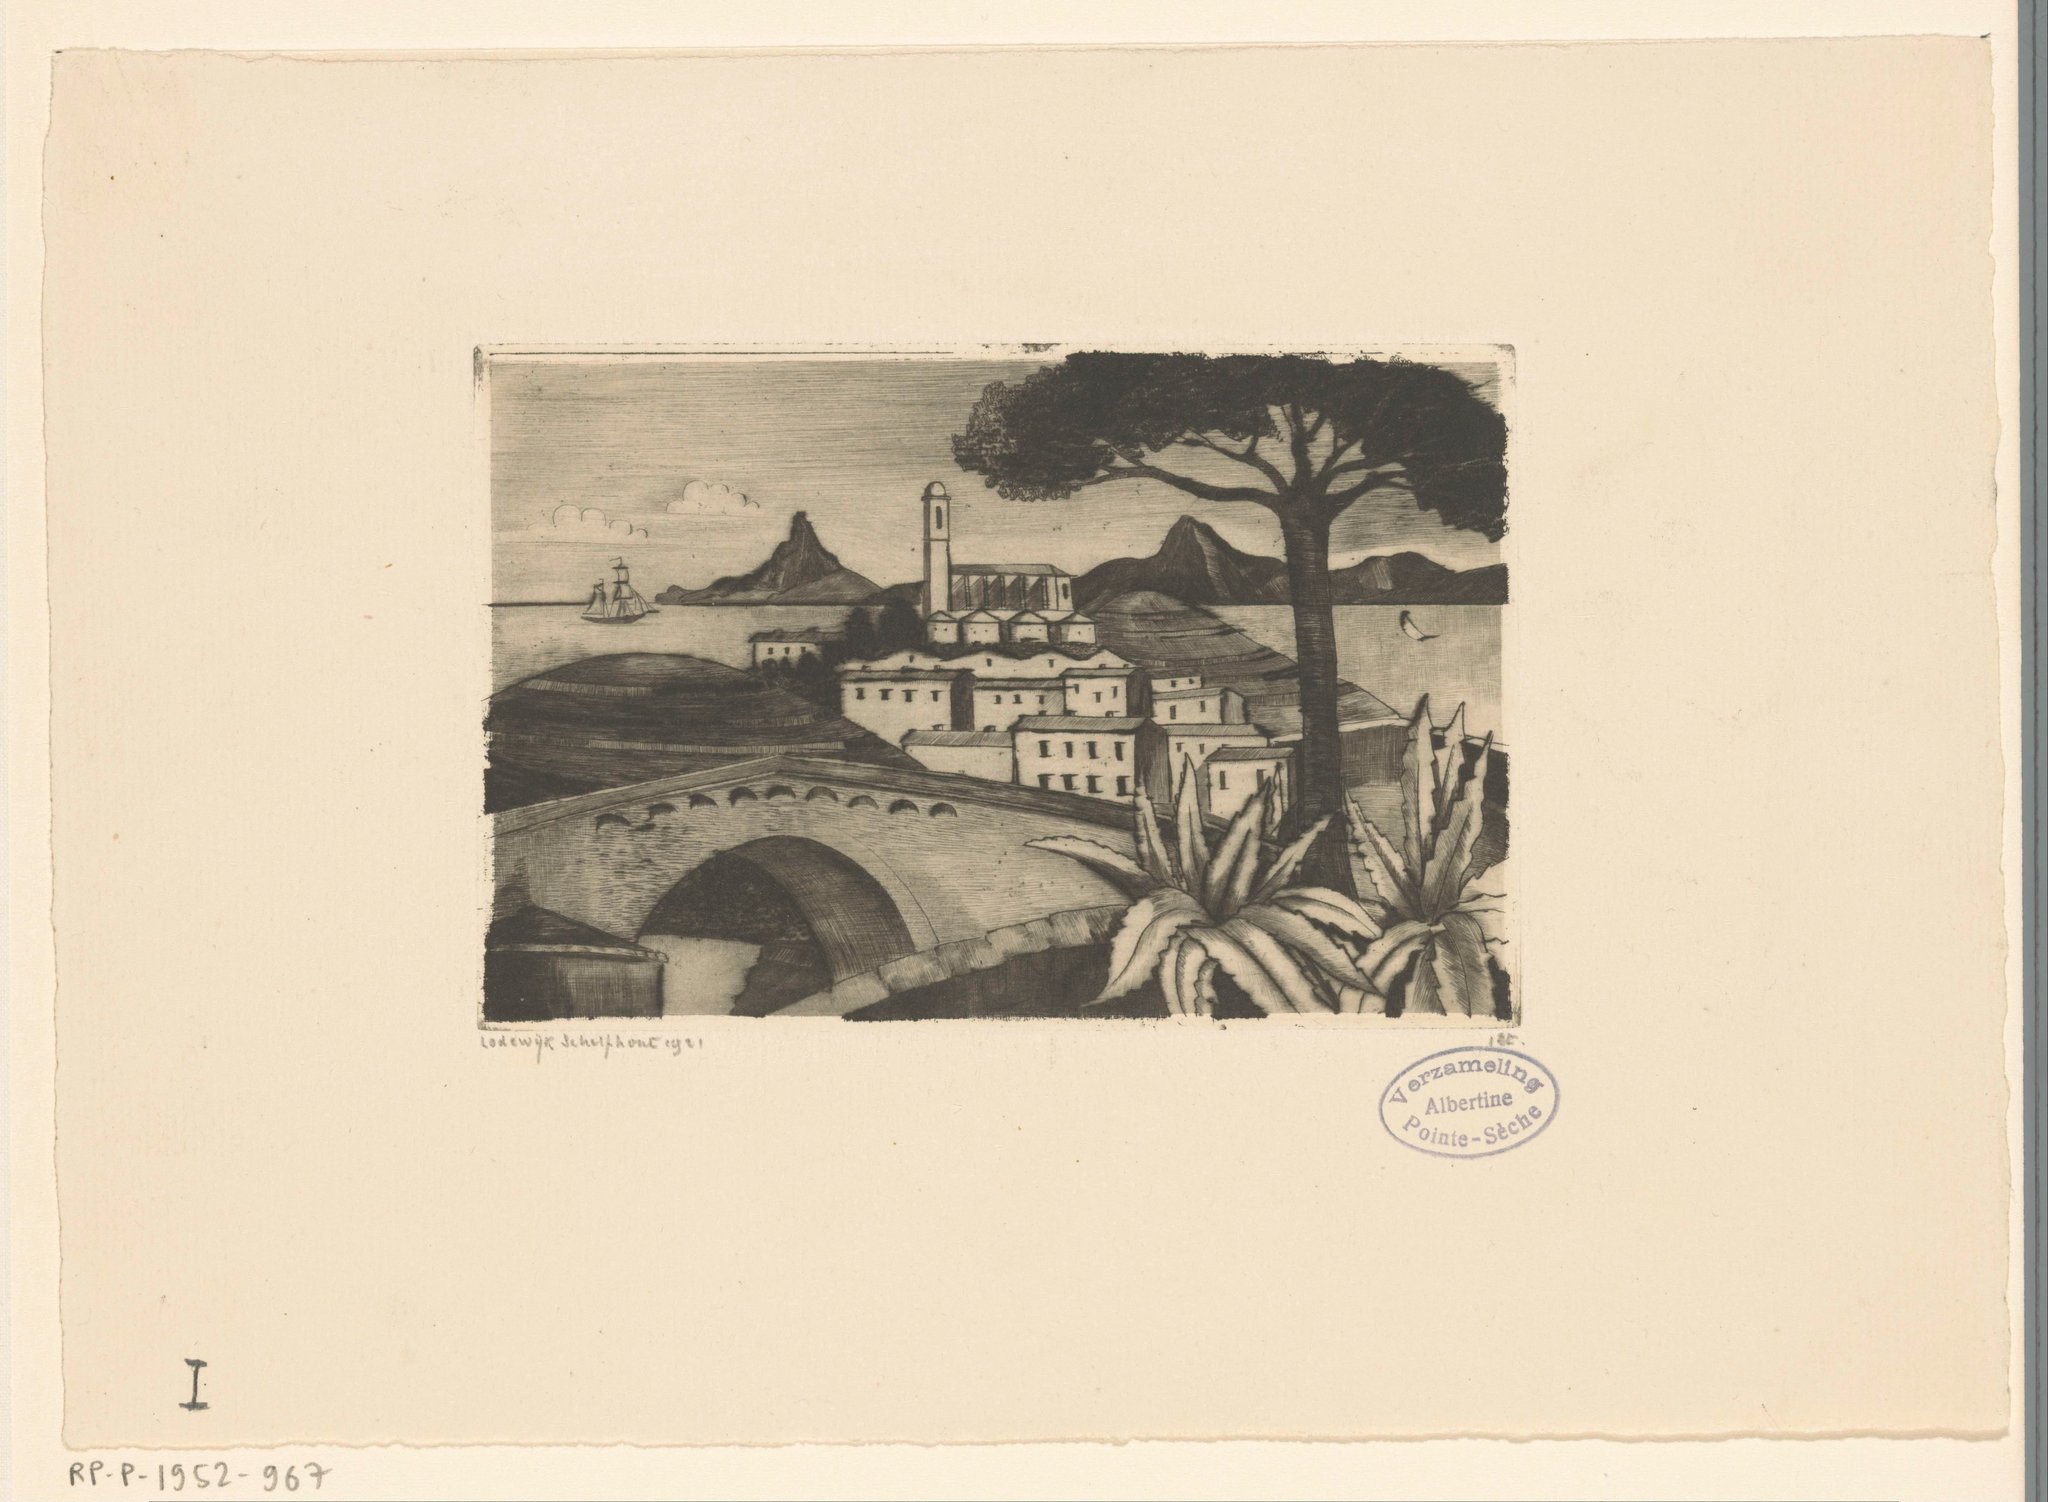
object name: print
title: Paysage Corse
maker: lodewijk schelfhout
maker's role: draughtsman, print maker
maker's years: 1881-1943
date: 1921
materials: paper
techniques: drypoint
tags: city-view, and landscape with man-made constructions, bridge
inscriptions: collector's mark: Lugt 5i, collector's mark: Lugt 2760, collector's mark: Lugt 2228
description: Een stad aan zee op Corsica. Op de voorgrond een brug.